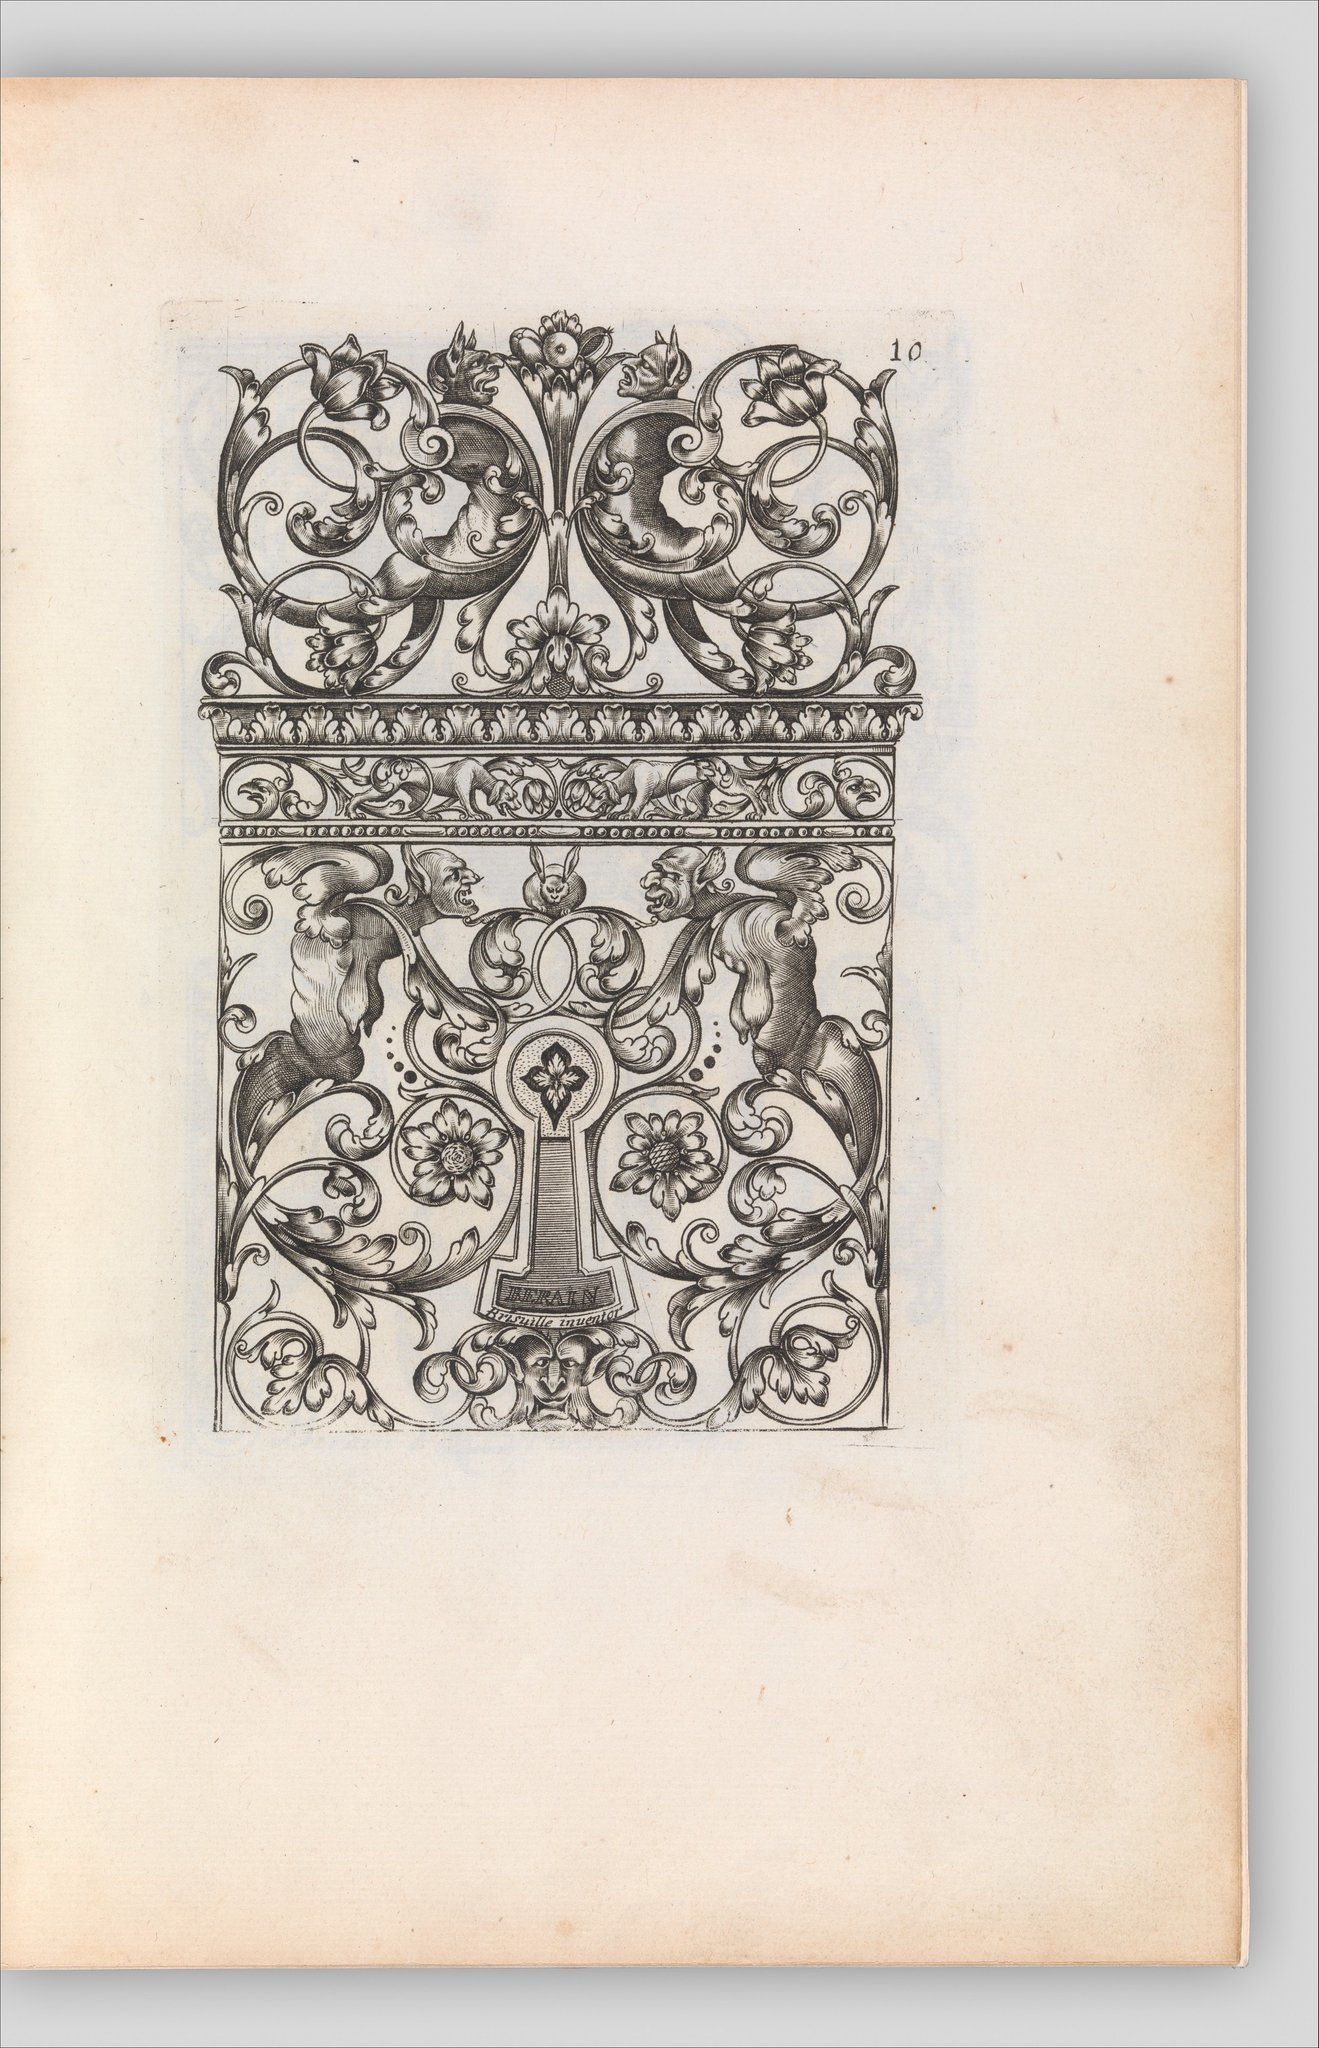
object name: album print ornament architecture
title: Diverses Pieces de Serruriers, page 11 (recto)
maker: jean berain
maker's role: artist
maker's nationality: french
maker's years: 1640-1711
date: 1663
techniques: engraving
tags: grotesques,ornament,dogs,rabbits,vines